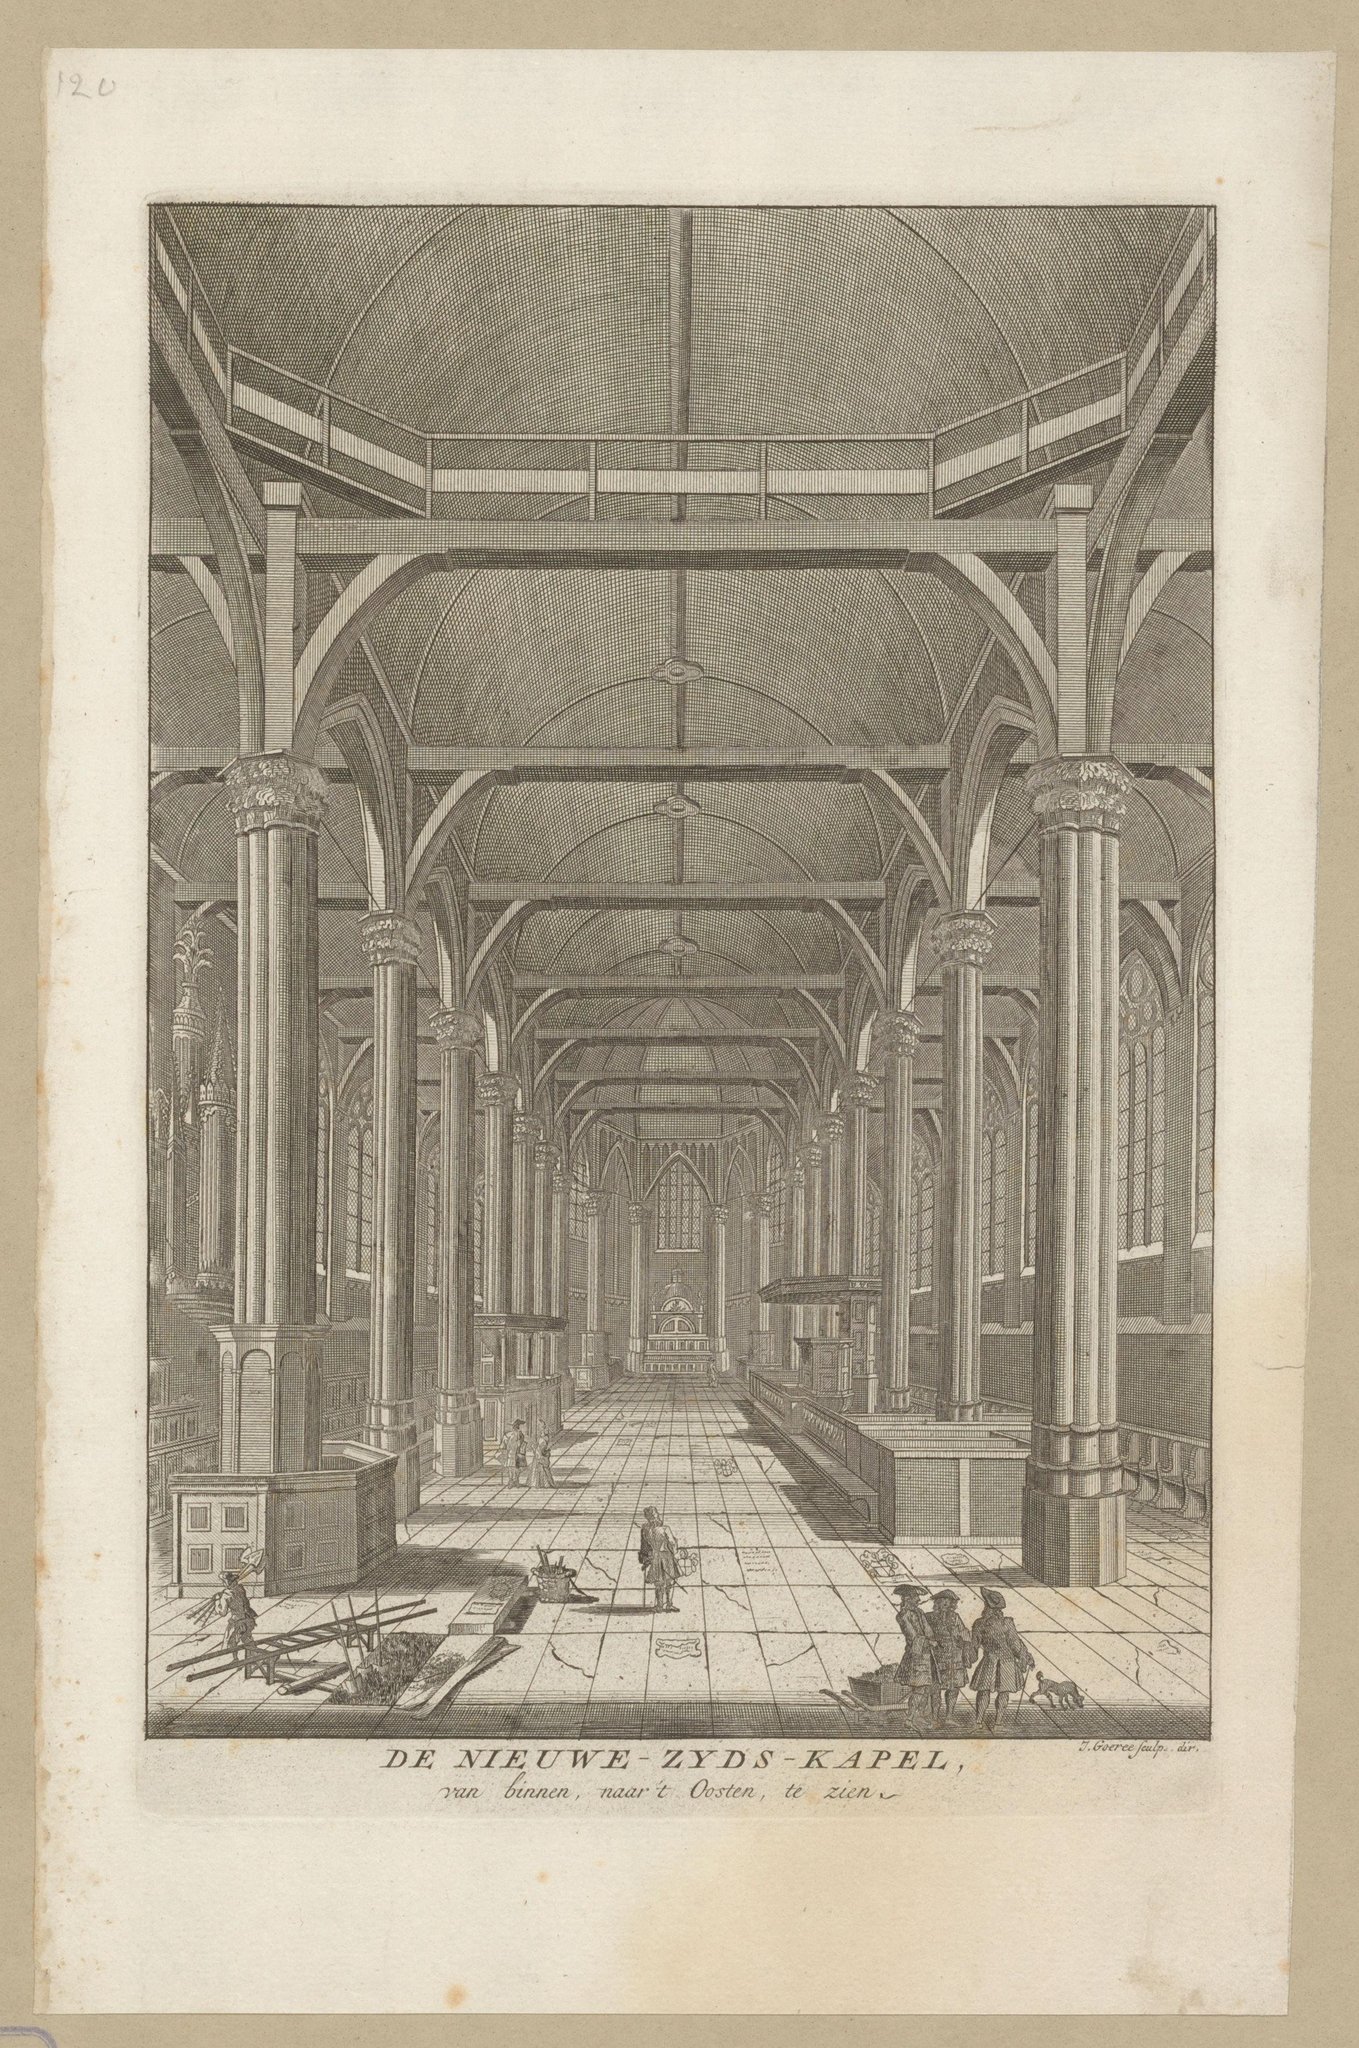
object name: print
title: De Nieuwe-Zyds-Kapel, van binnen, naar 't Oosten, te zien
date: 1765-1782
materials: paper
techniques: engraving, etching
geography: amsterdam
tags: interior of church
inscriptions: collector's mark: Lugt 1641b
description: Prent mogelijk uit: Wagenaar, Jan. Amsterdam, in zyne opkomst, aanwas, geschiedenissen (…). Amsterdam: Isaak Tirion, 1765, dl. 2. Of uit: Verzameling der fraaiste gezigten van Amsterdam in negen en zeventig afbeeldingen. Amsterdam en Harlingen: Petrus Conradi en Volkert van der Plaats, 1782.